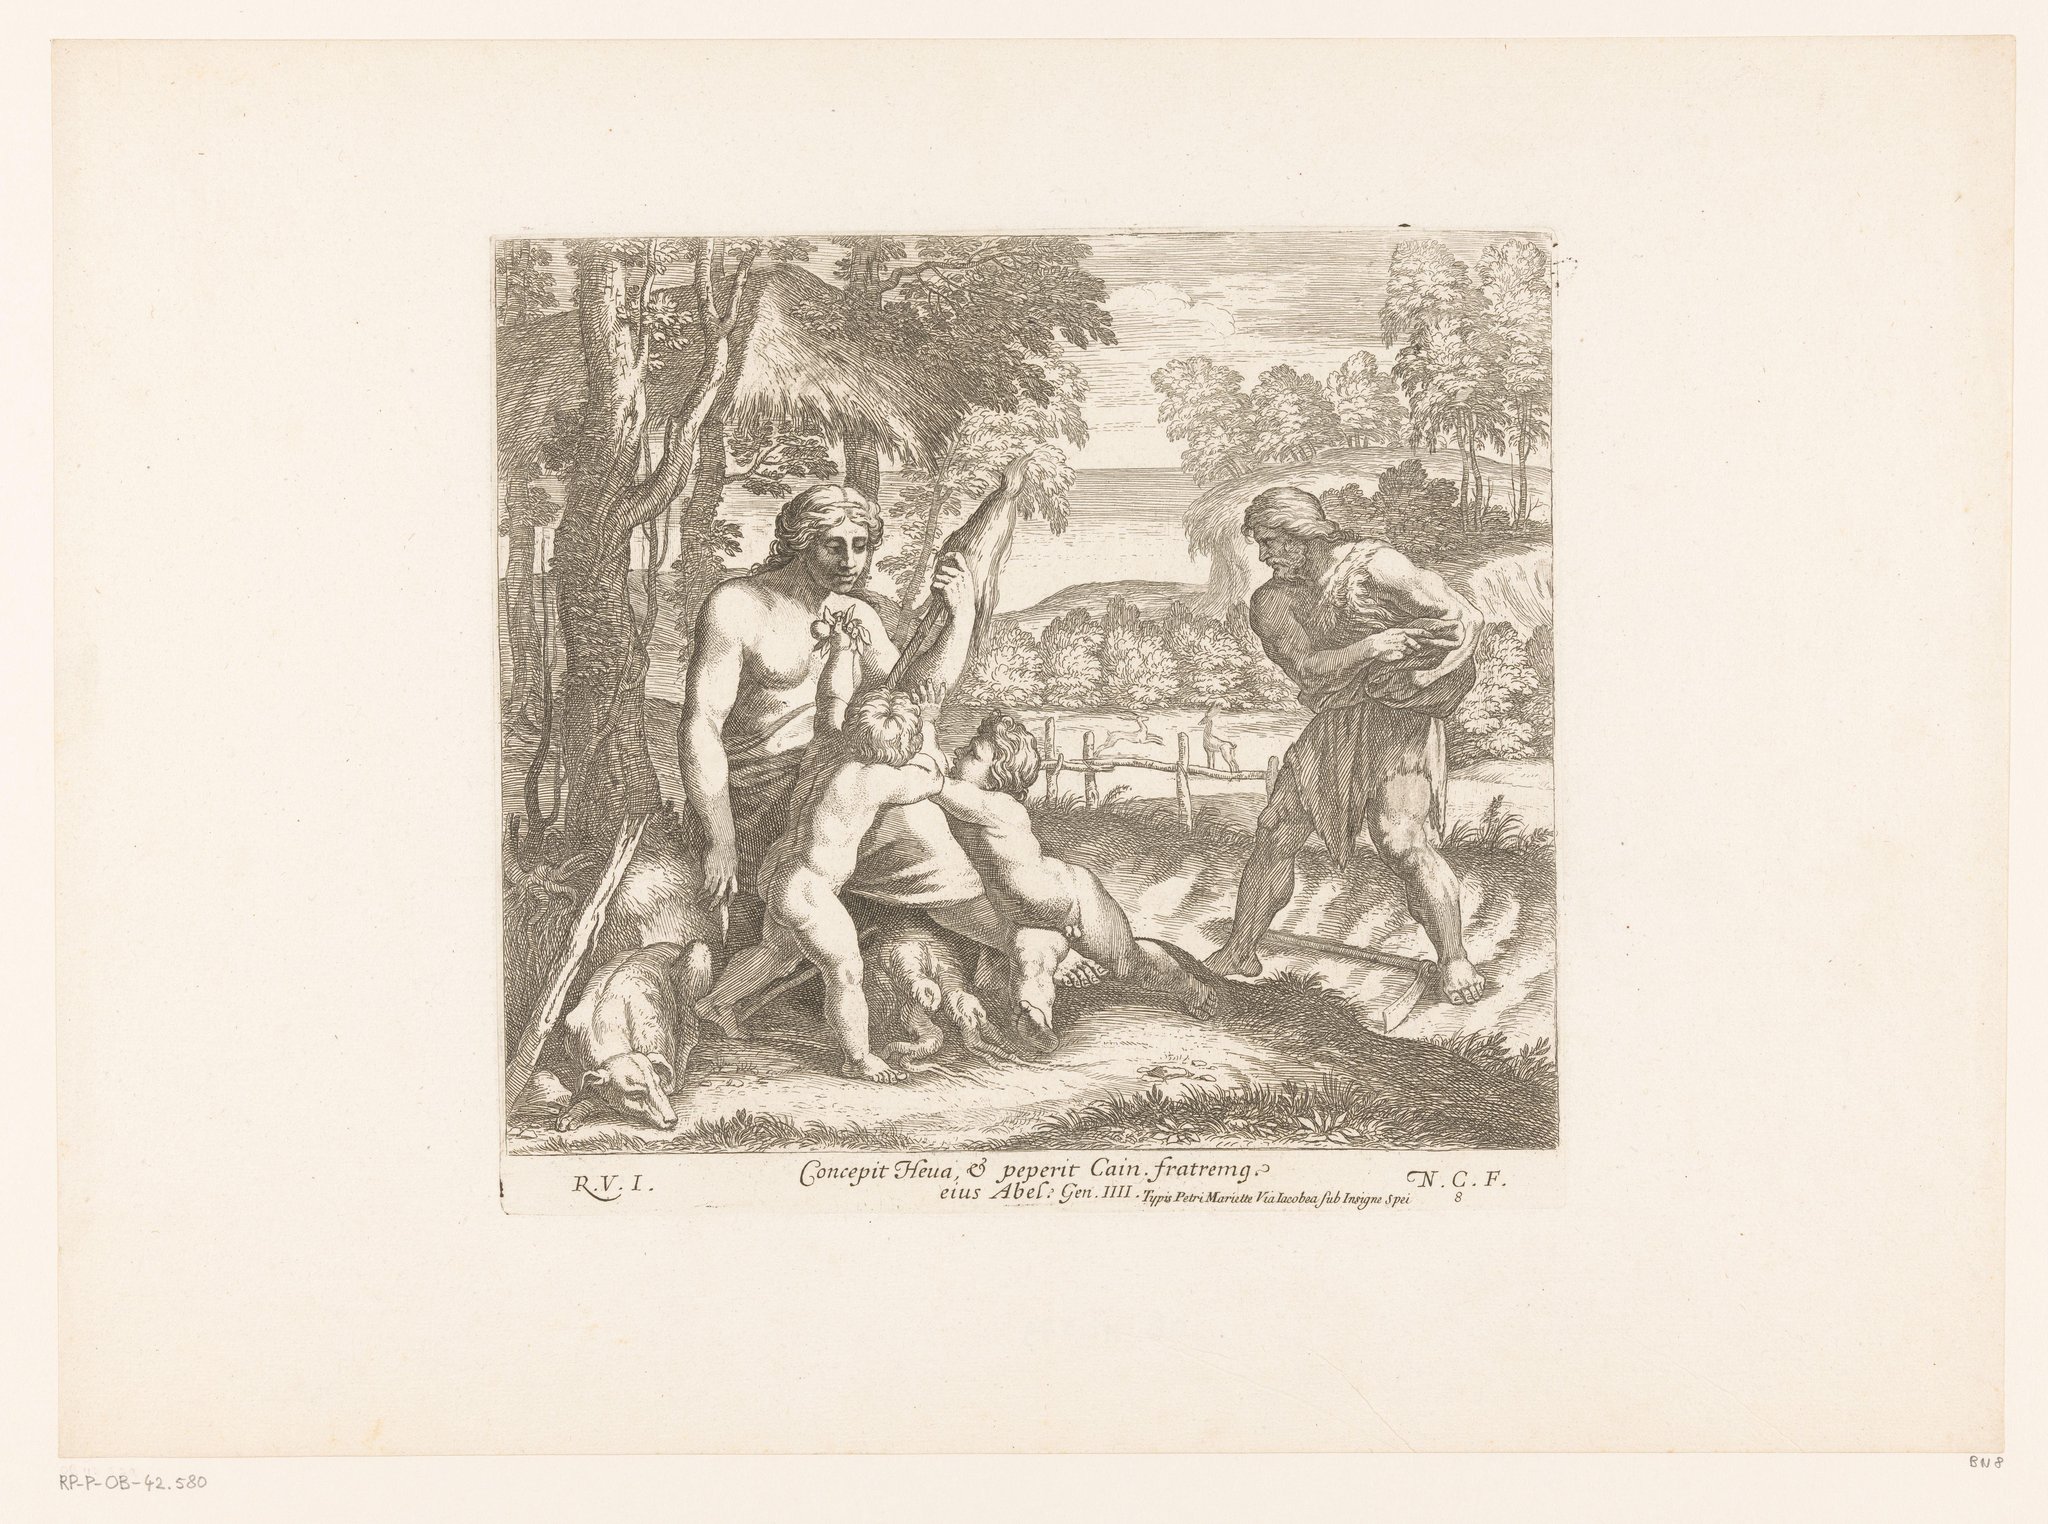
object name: print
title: Rafaël Bijbel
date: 1649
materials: paper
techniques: etching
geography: vatican city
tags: the building of the ark, and the embarkation (genesis 7:5-9)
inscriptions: collector's mark: Lugt 2228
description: Prent uit de Sacrae Historiae Acta a Raphael Urbin in Vaticanis xystis ad picturae miraculum expressa, ook bekend als de Rafaël Bijbel. De serie bestaat uit 54 platen, waarvan twee titelprenten, de eerste met een opdracht aan Rafaël, de tweede met een opdracht aan Renard. De overige 52 platen betreffen composities naar schilderingen in de Loggia van Rafaël in het Vaticaan. De serie werd in 1649 uitgegeven door Pierre Mariette te Parijs.